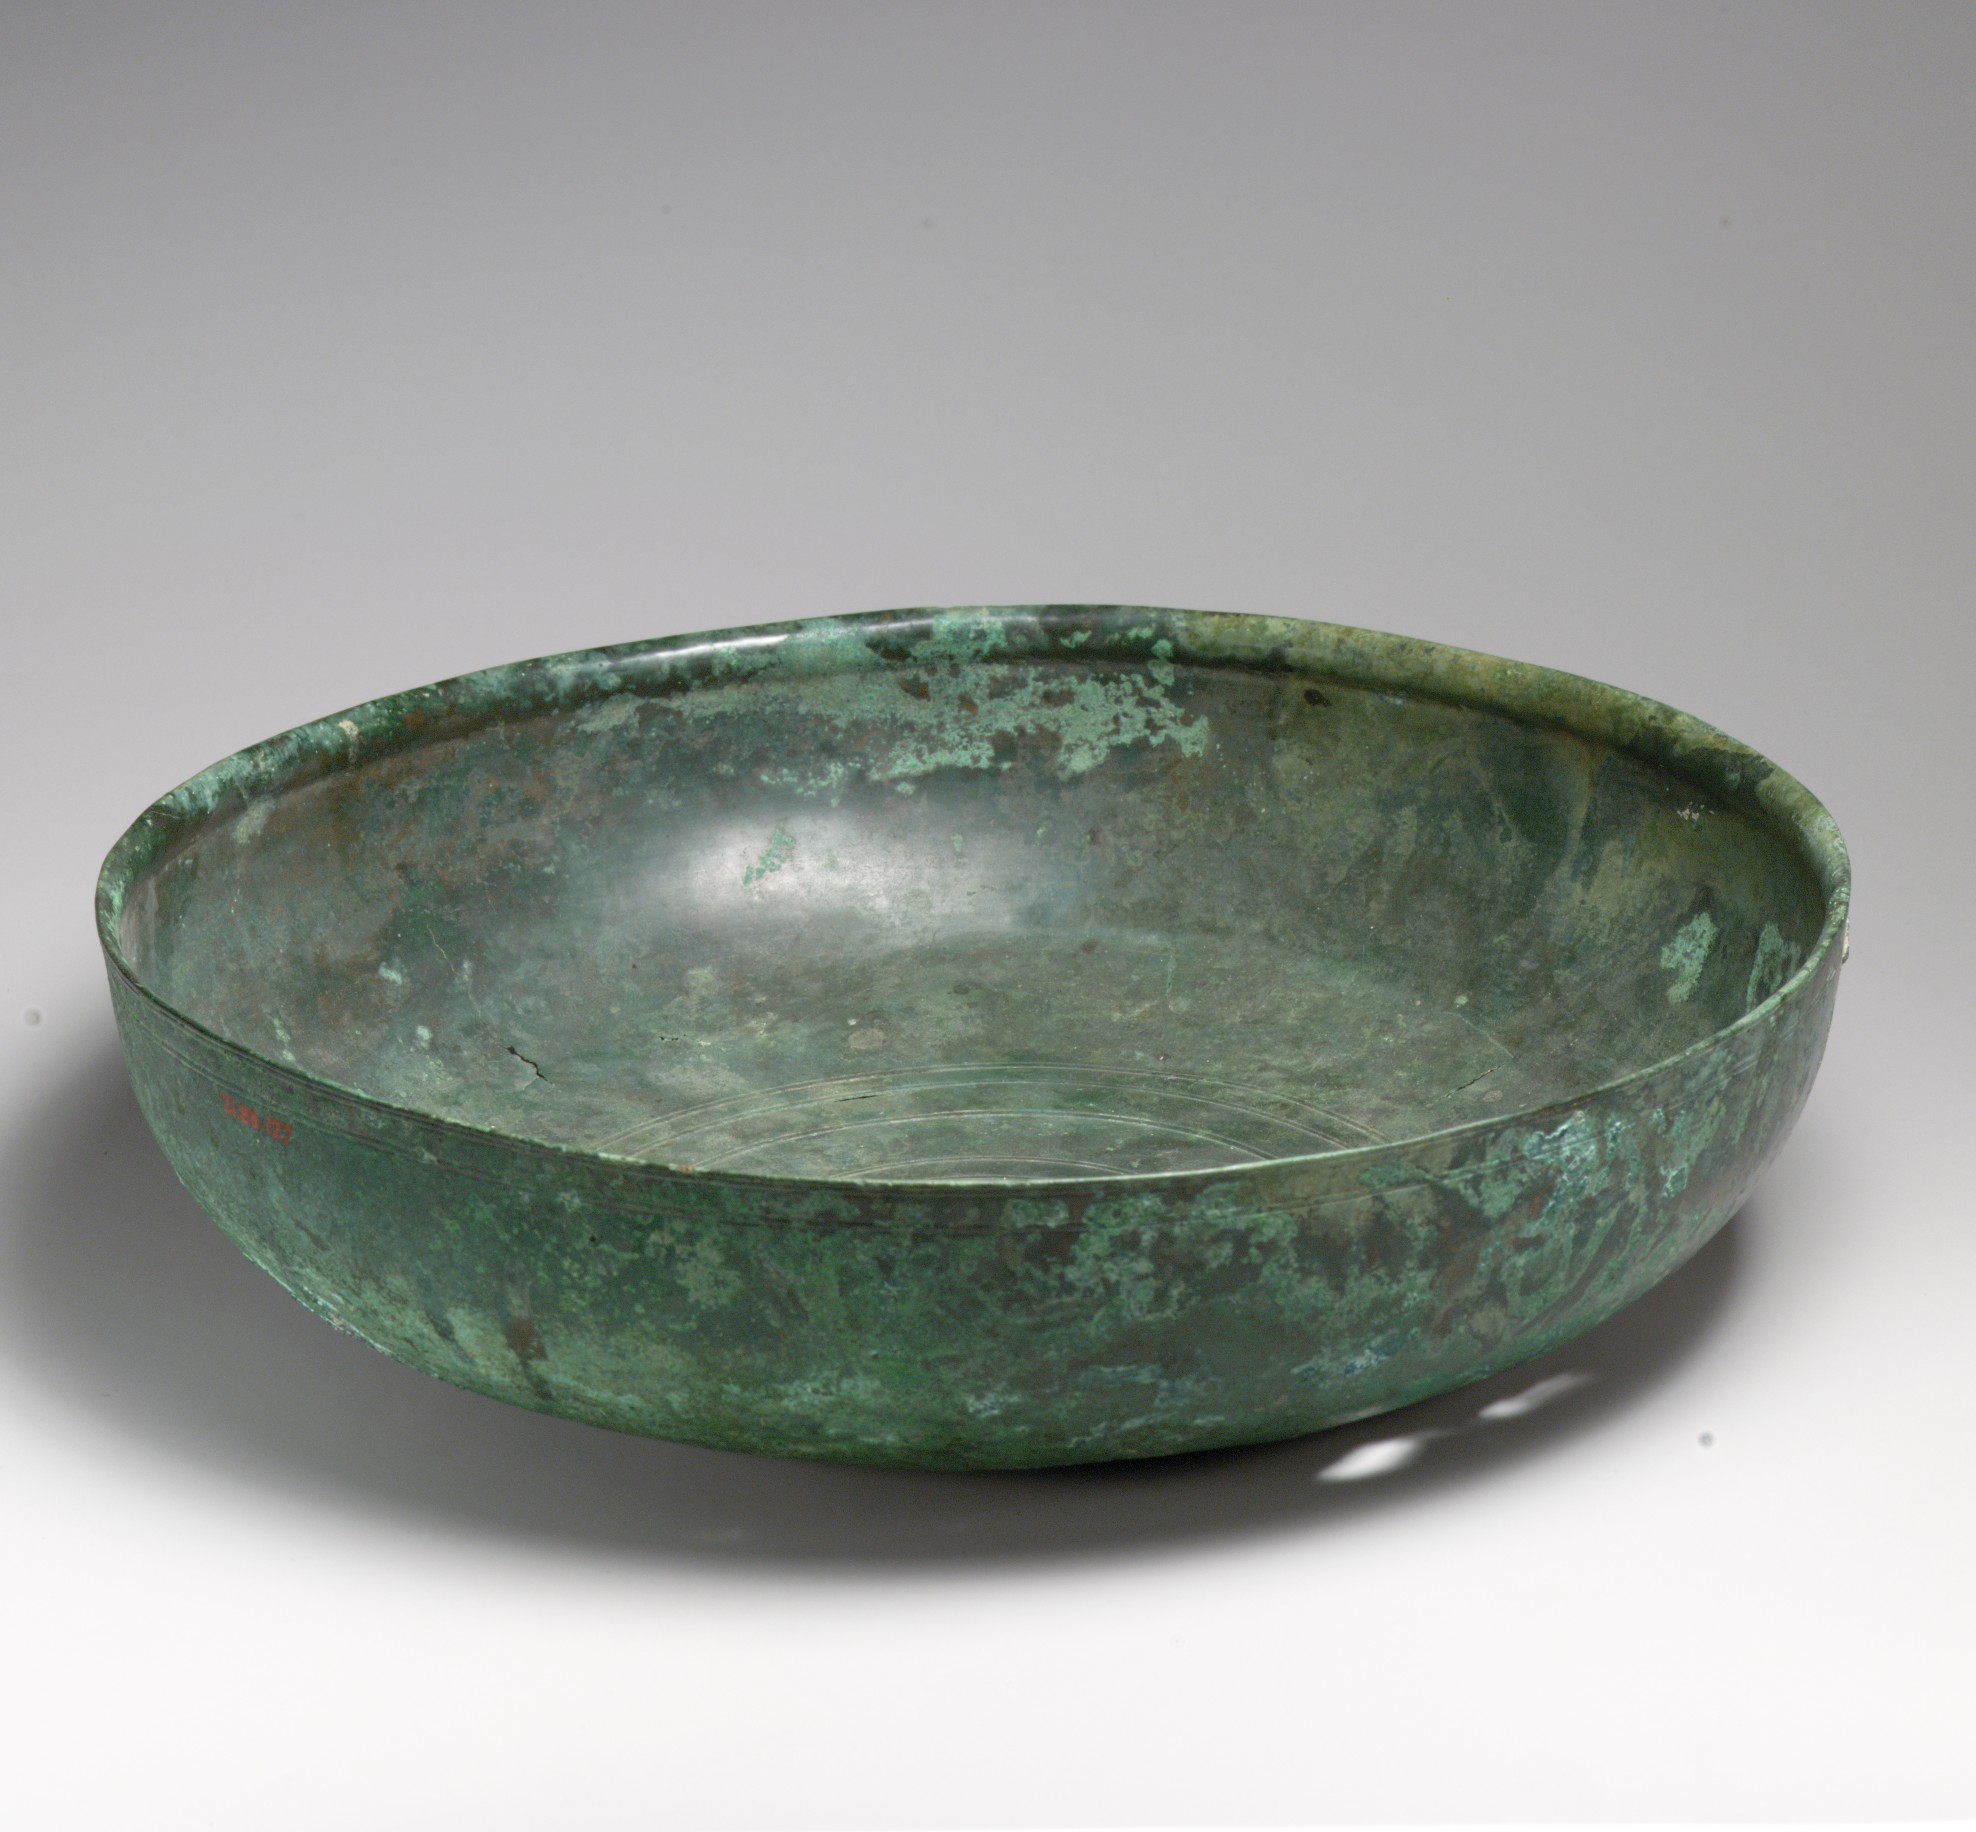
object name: bowl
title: Bronze shallow bowl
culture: etruscan or roman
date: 101-200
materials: bronze